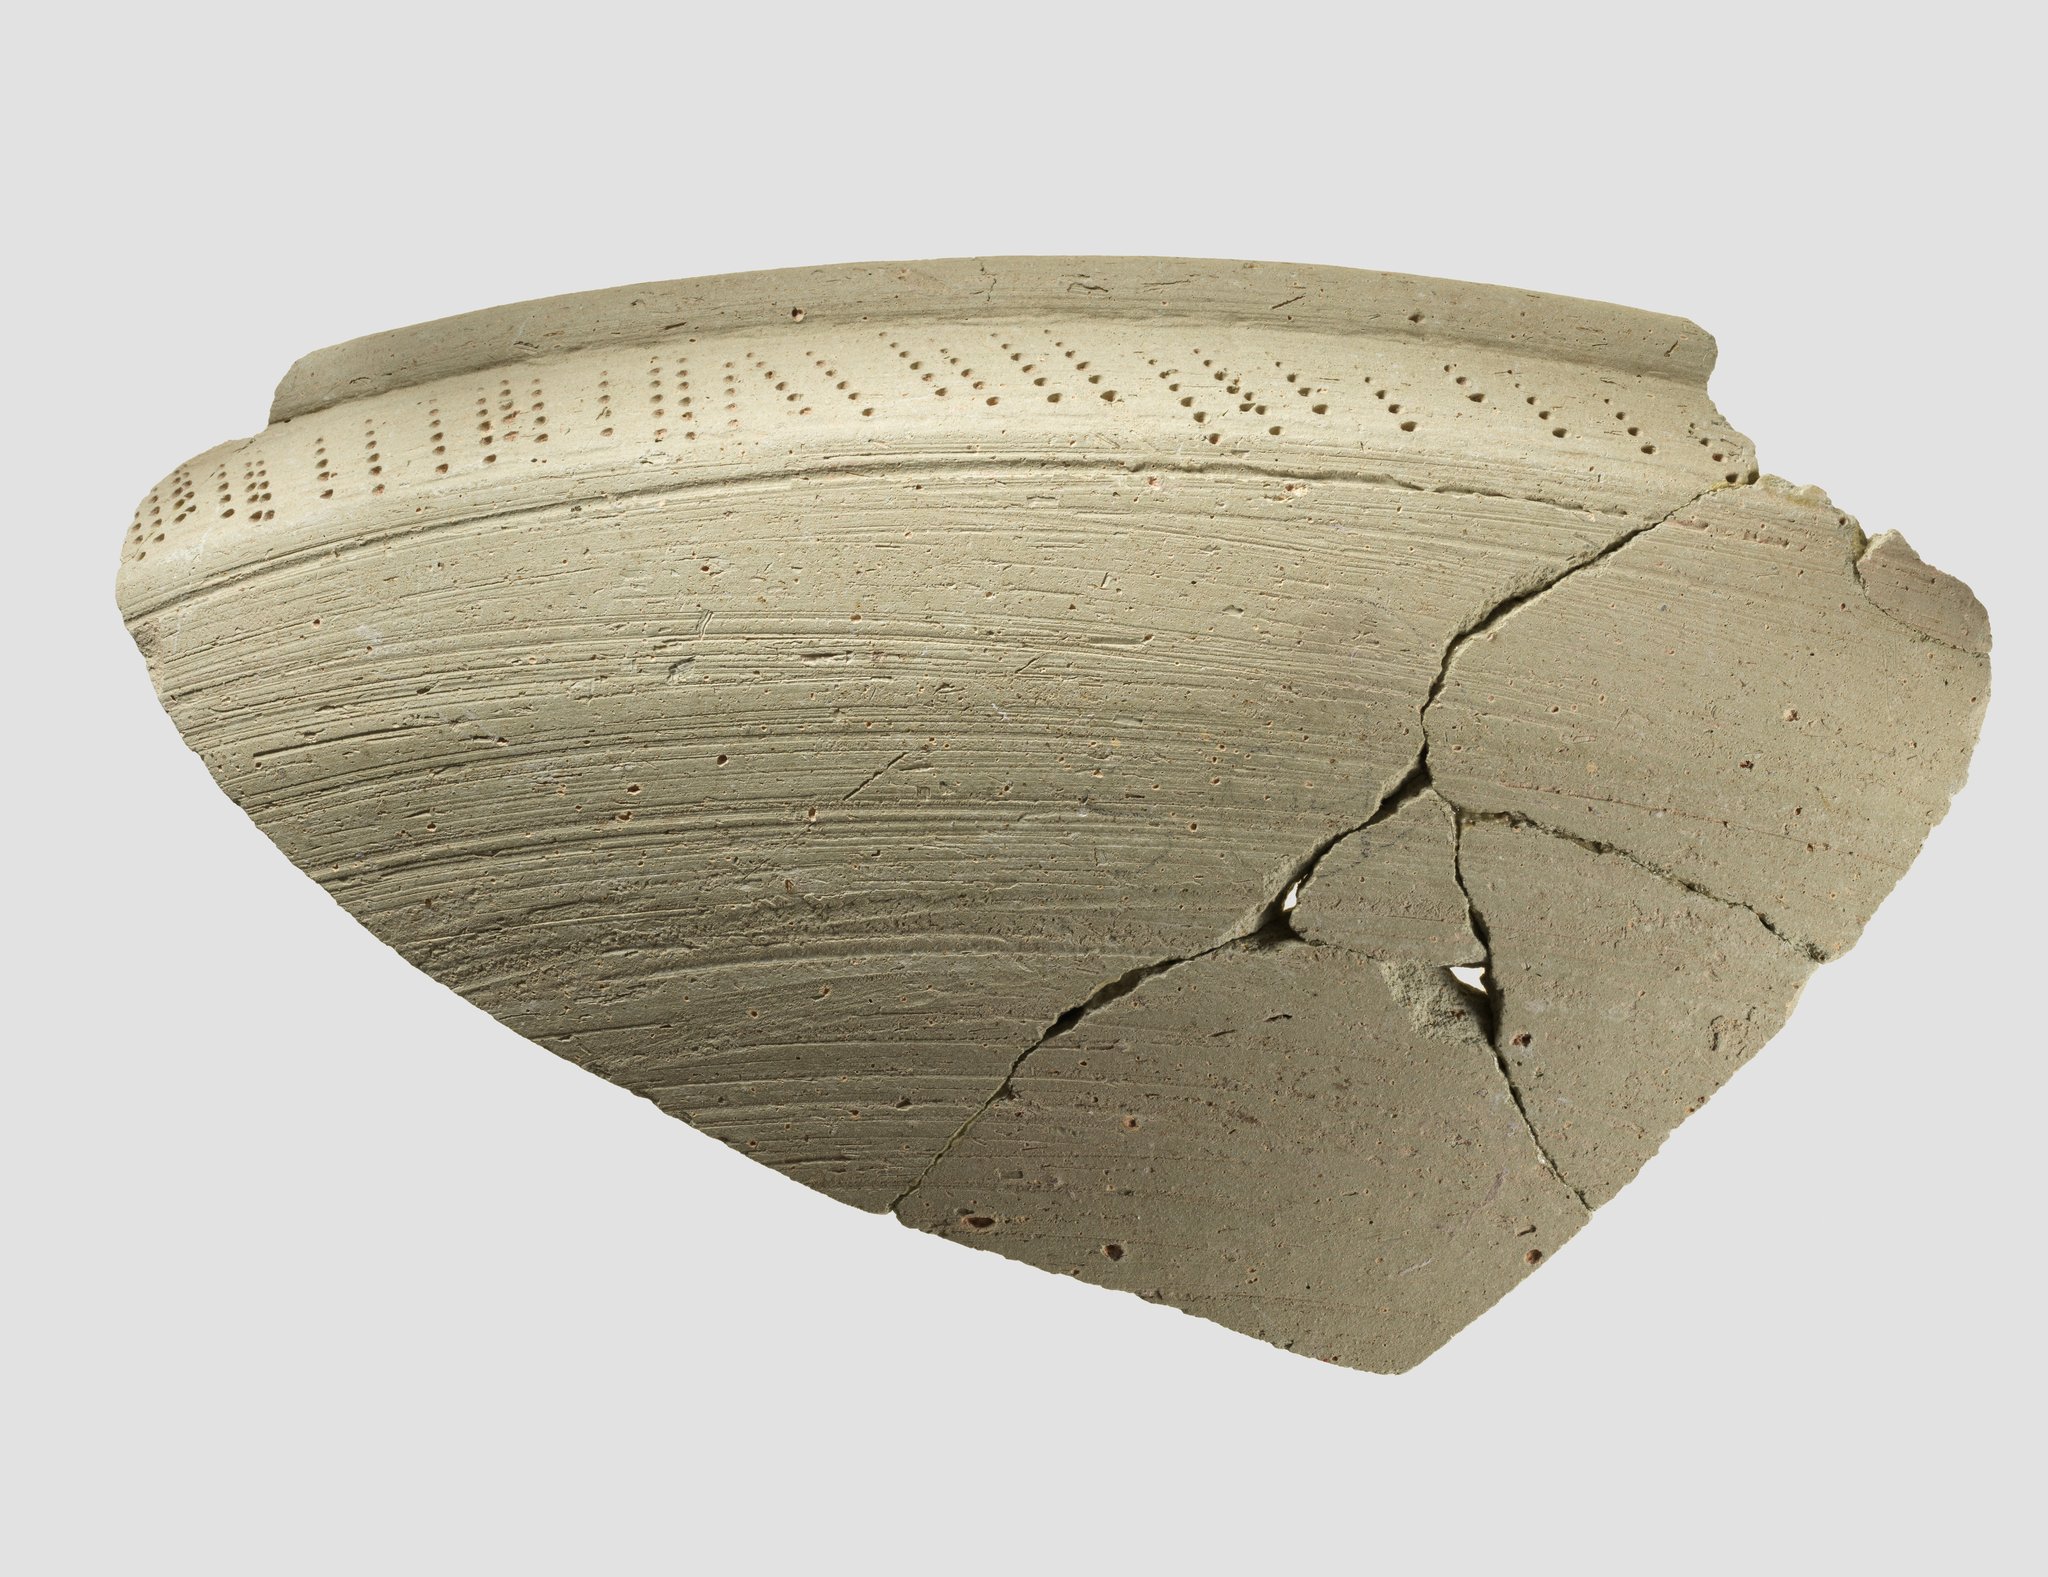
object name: bowl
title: Carinated bowl sherd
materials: ceramic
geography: mesopotamia